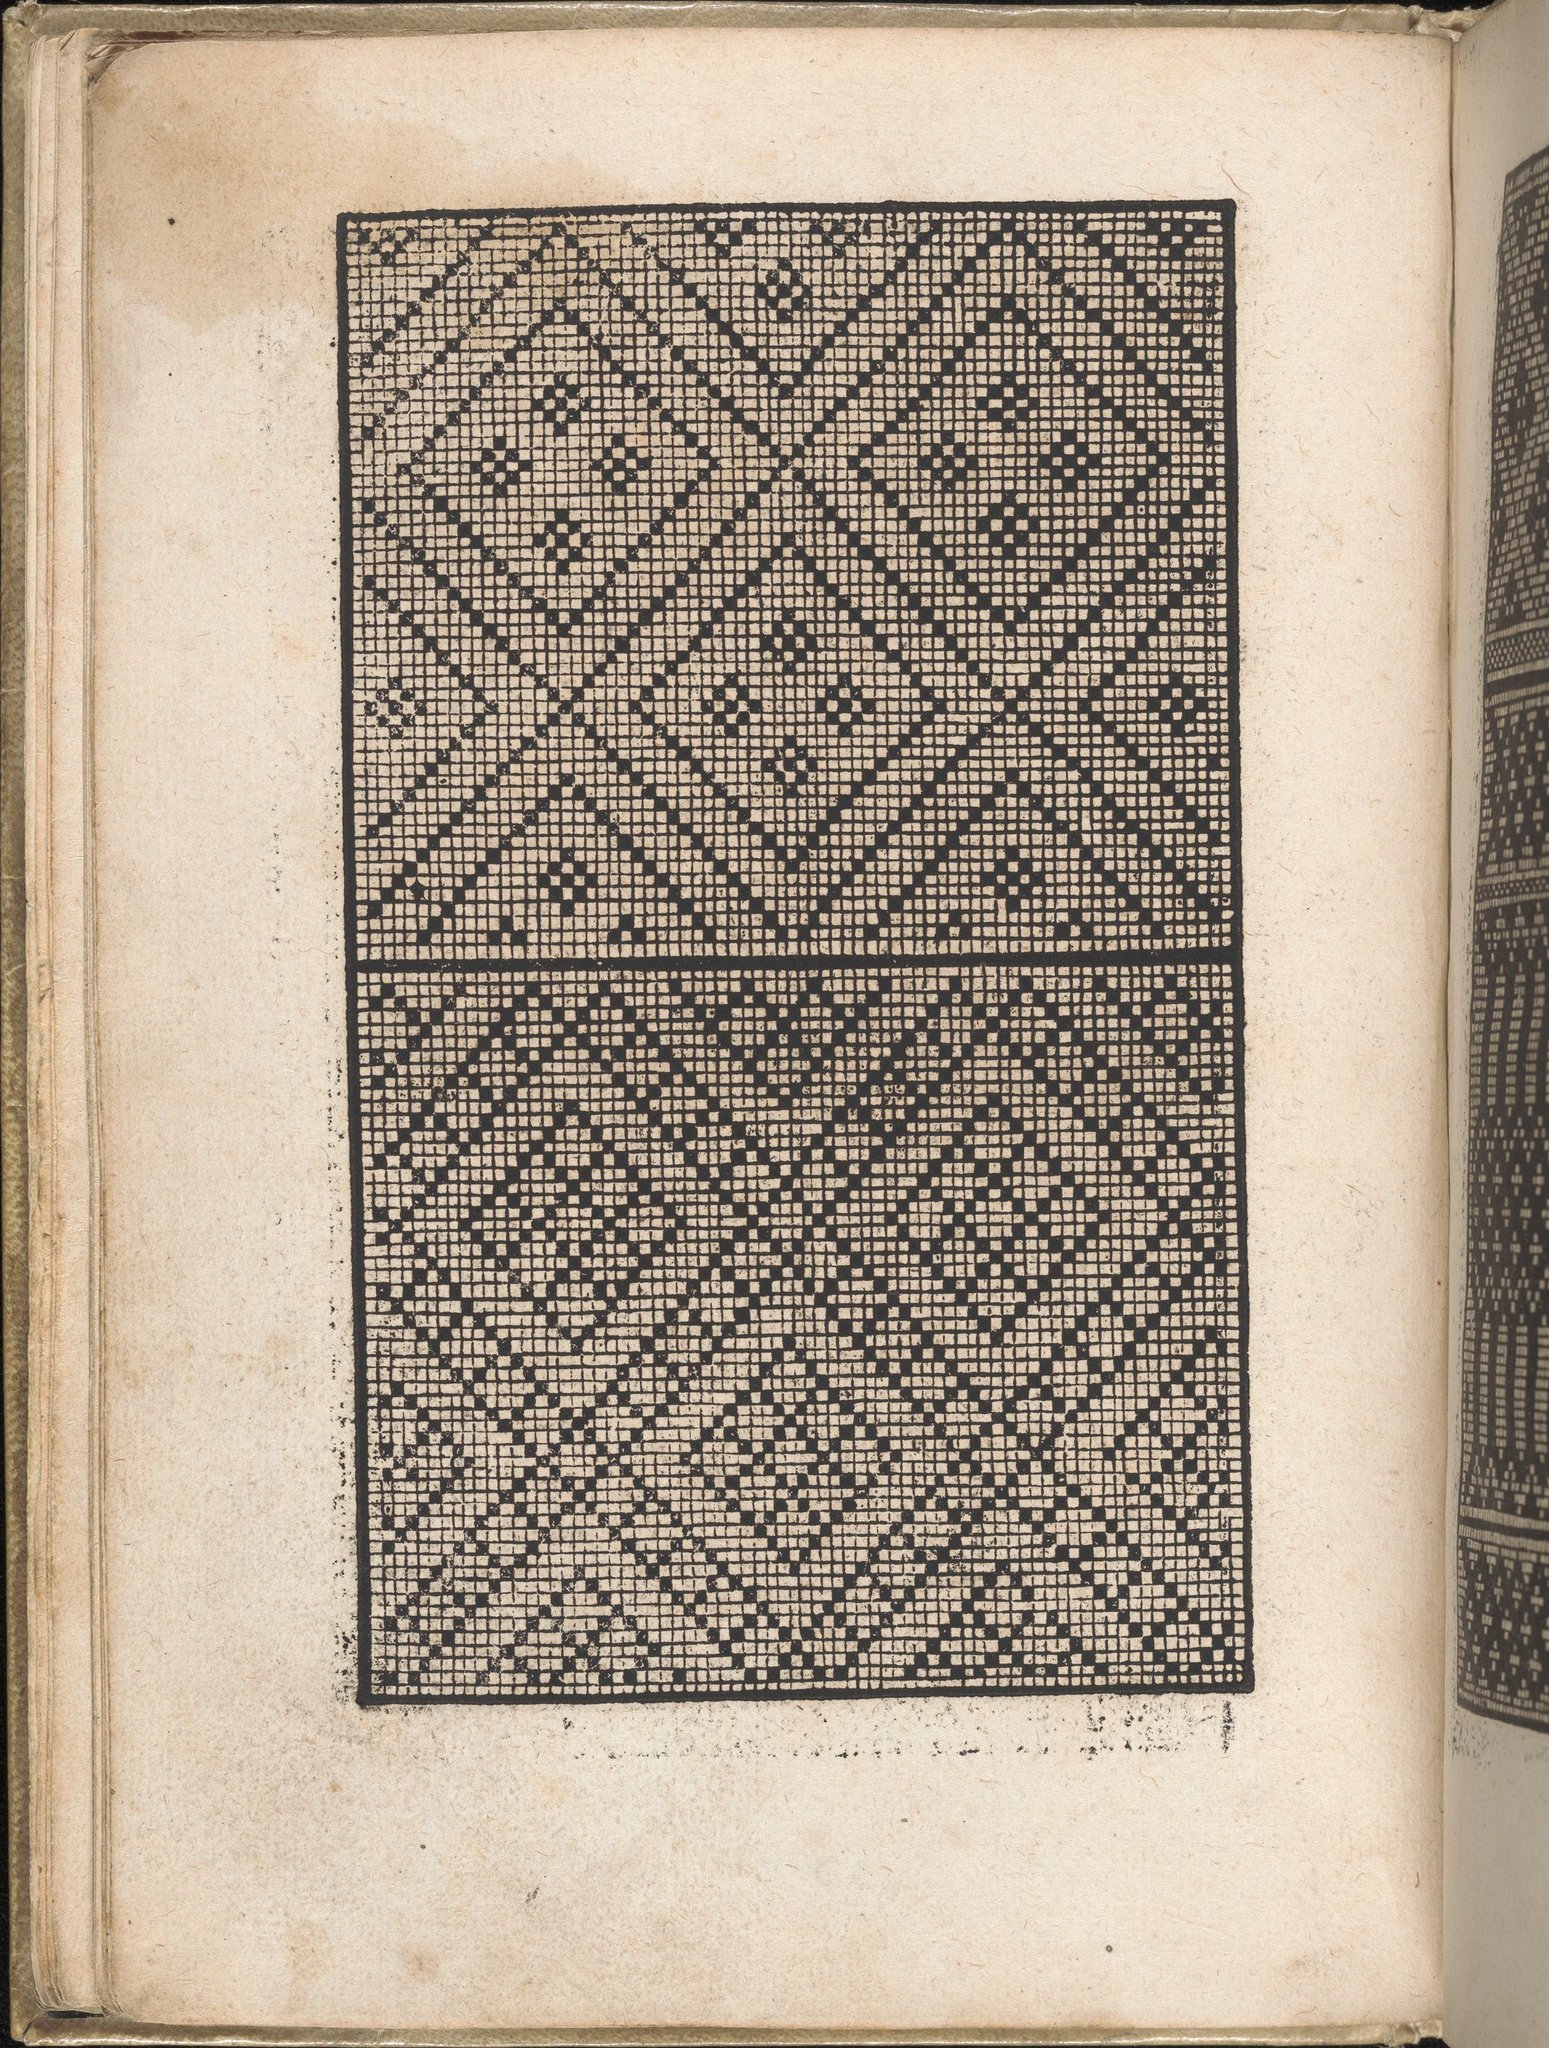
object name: book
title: Page 12r, from "Eyn New Kunstlichboich"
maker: peter quentel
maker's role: publisher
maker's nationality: german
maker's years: 1500-1550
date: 1529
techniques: woodcut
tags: ornament